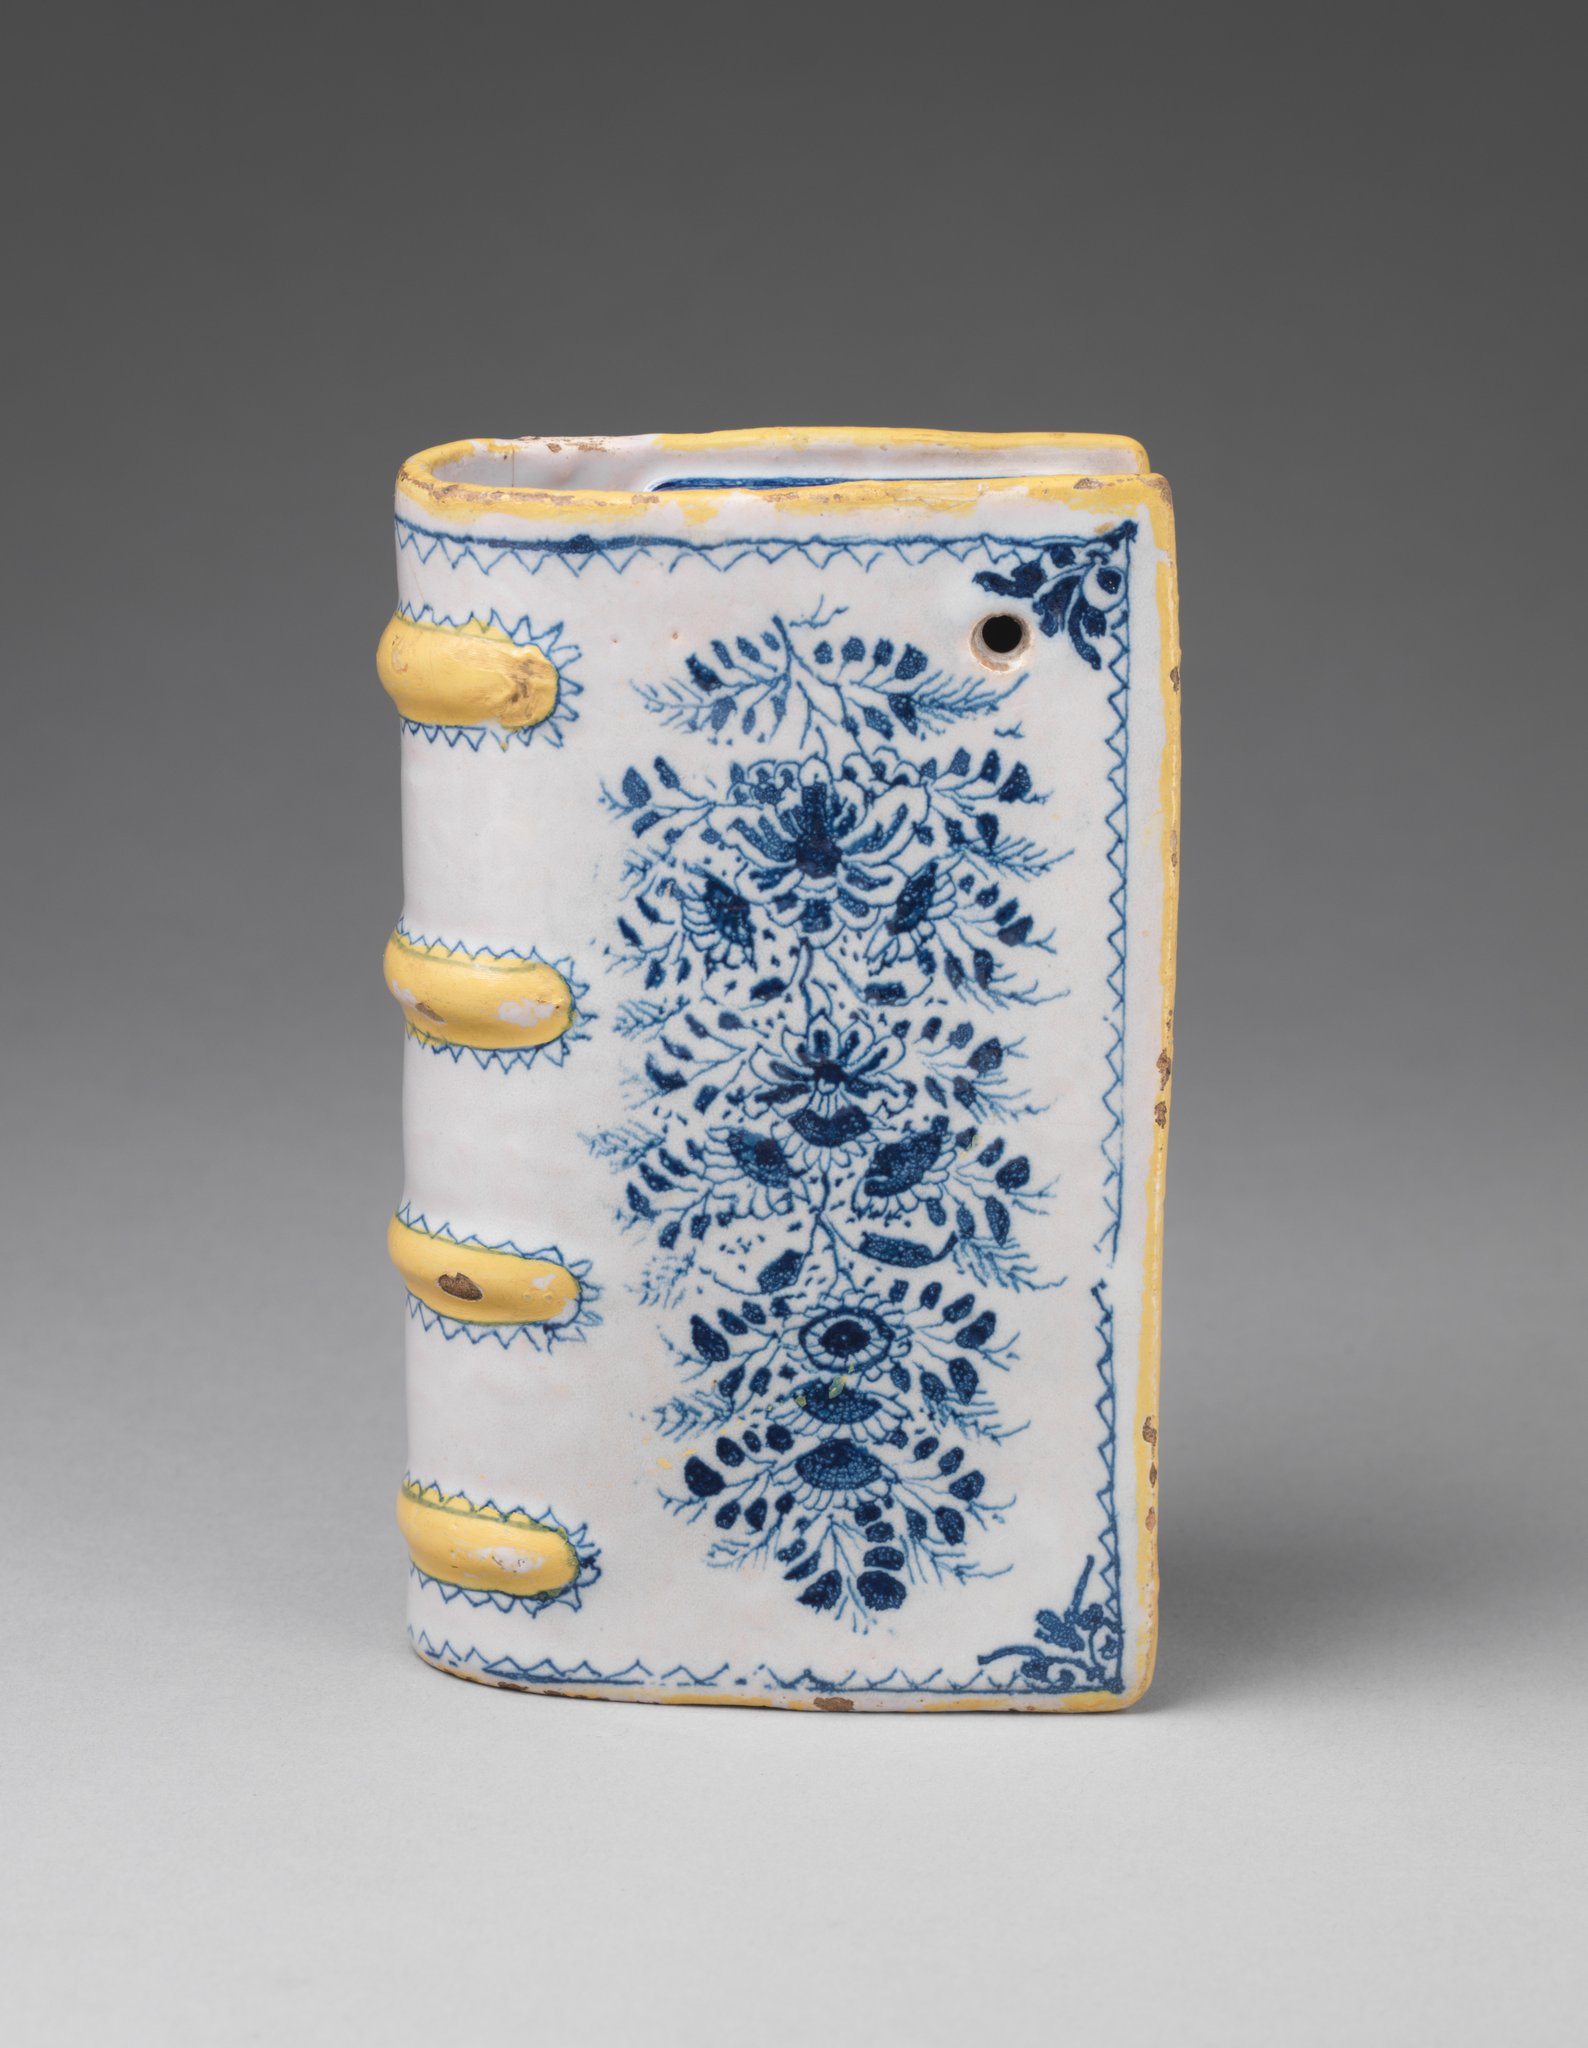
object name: hand warmer or flask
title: Hand warmer or flask in the shape of a book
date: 1701-1750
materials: earthenware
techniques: glazing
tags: books